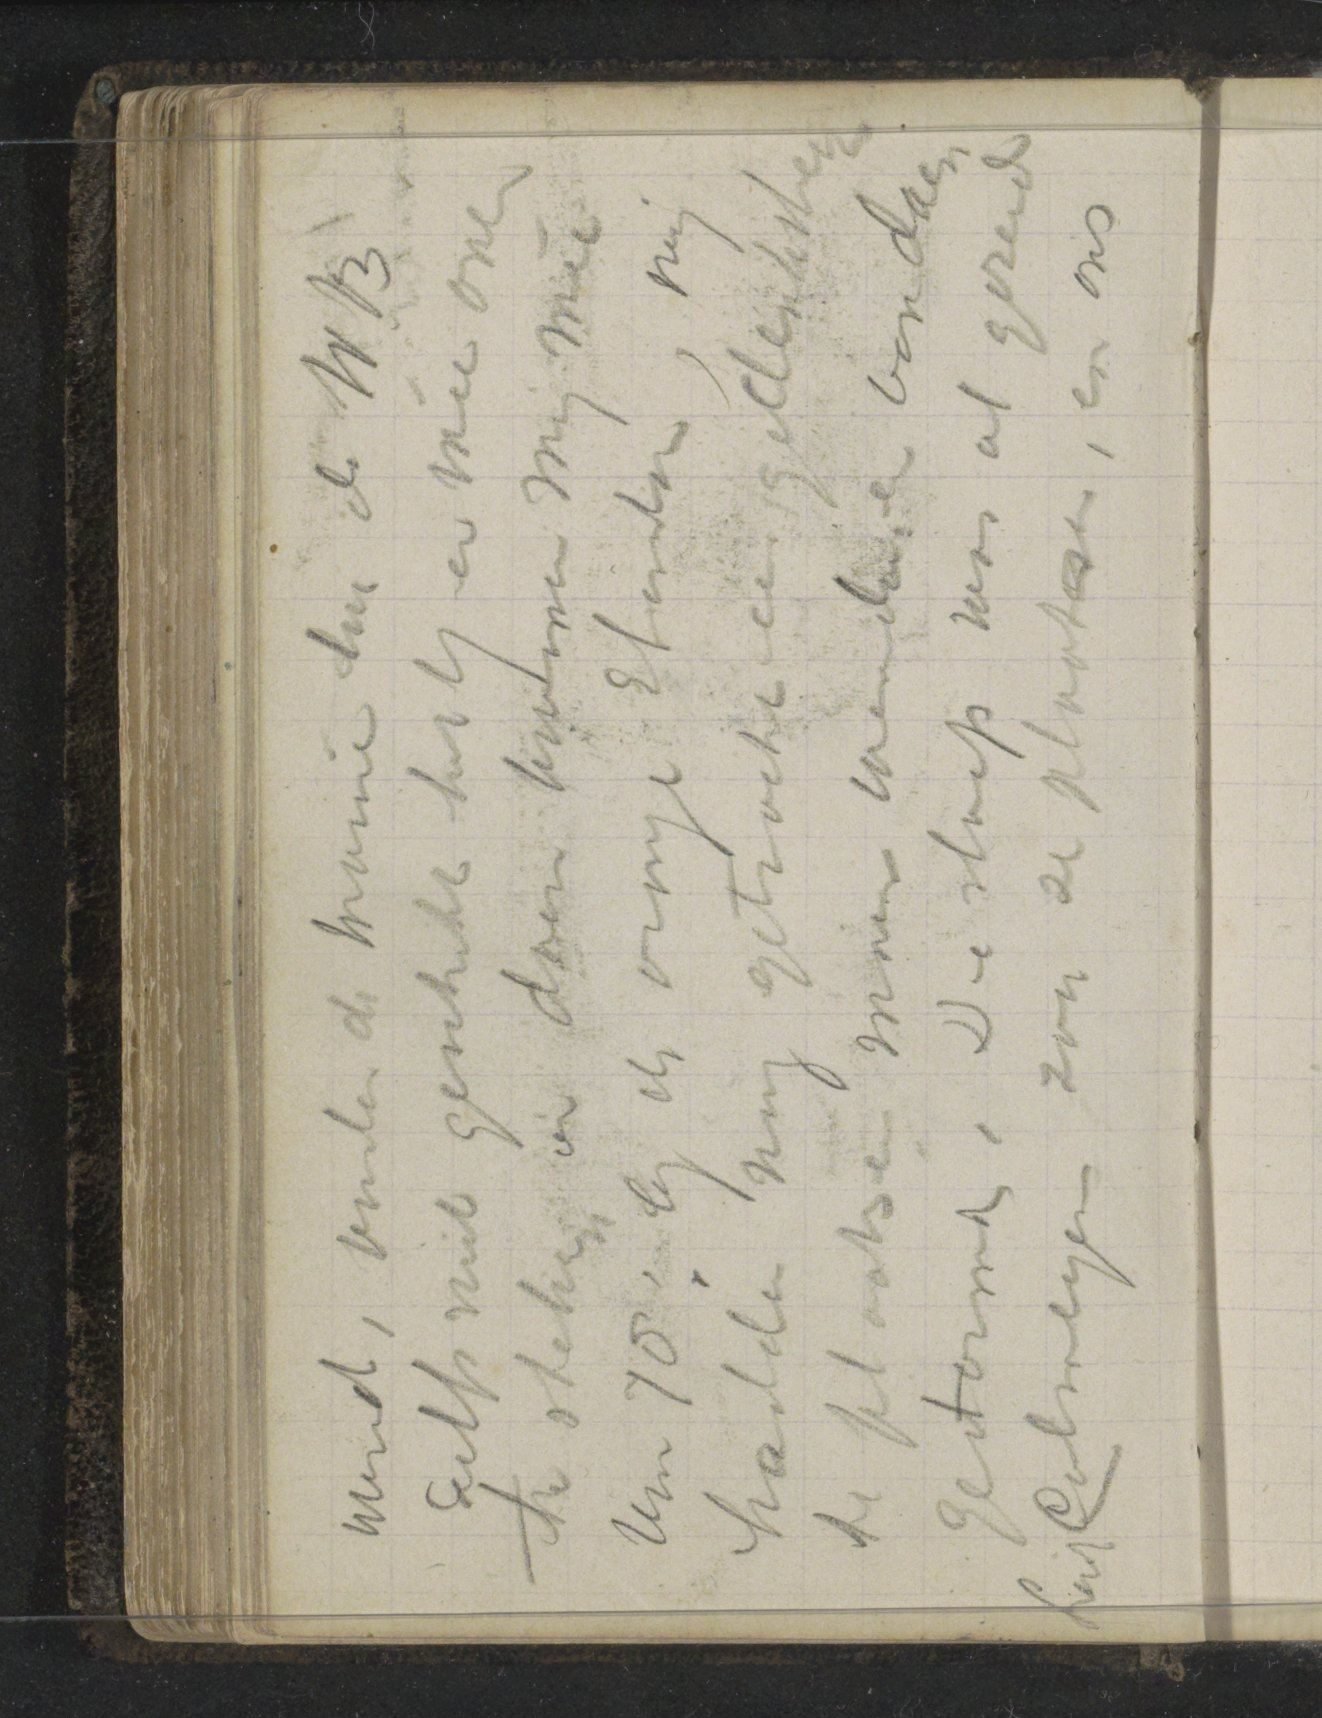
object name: sketchbook leaf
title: Reisverslag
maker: louis apol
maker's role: draughtsman, painter, print maker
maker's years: 1850-1936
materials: pencil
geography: barentsz sea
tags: nova zembla expedities 1880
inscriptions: annotation: ‘[...]’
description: Blad 66 verso uit een schetsboek met 110 bladen betekend tijdens de expeditie naar Nova Zembla in 1880.